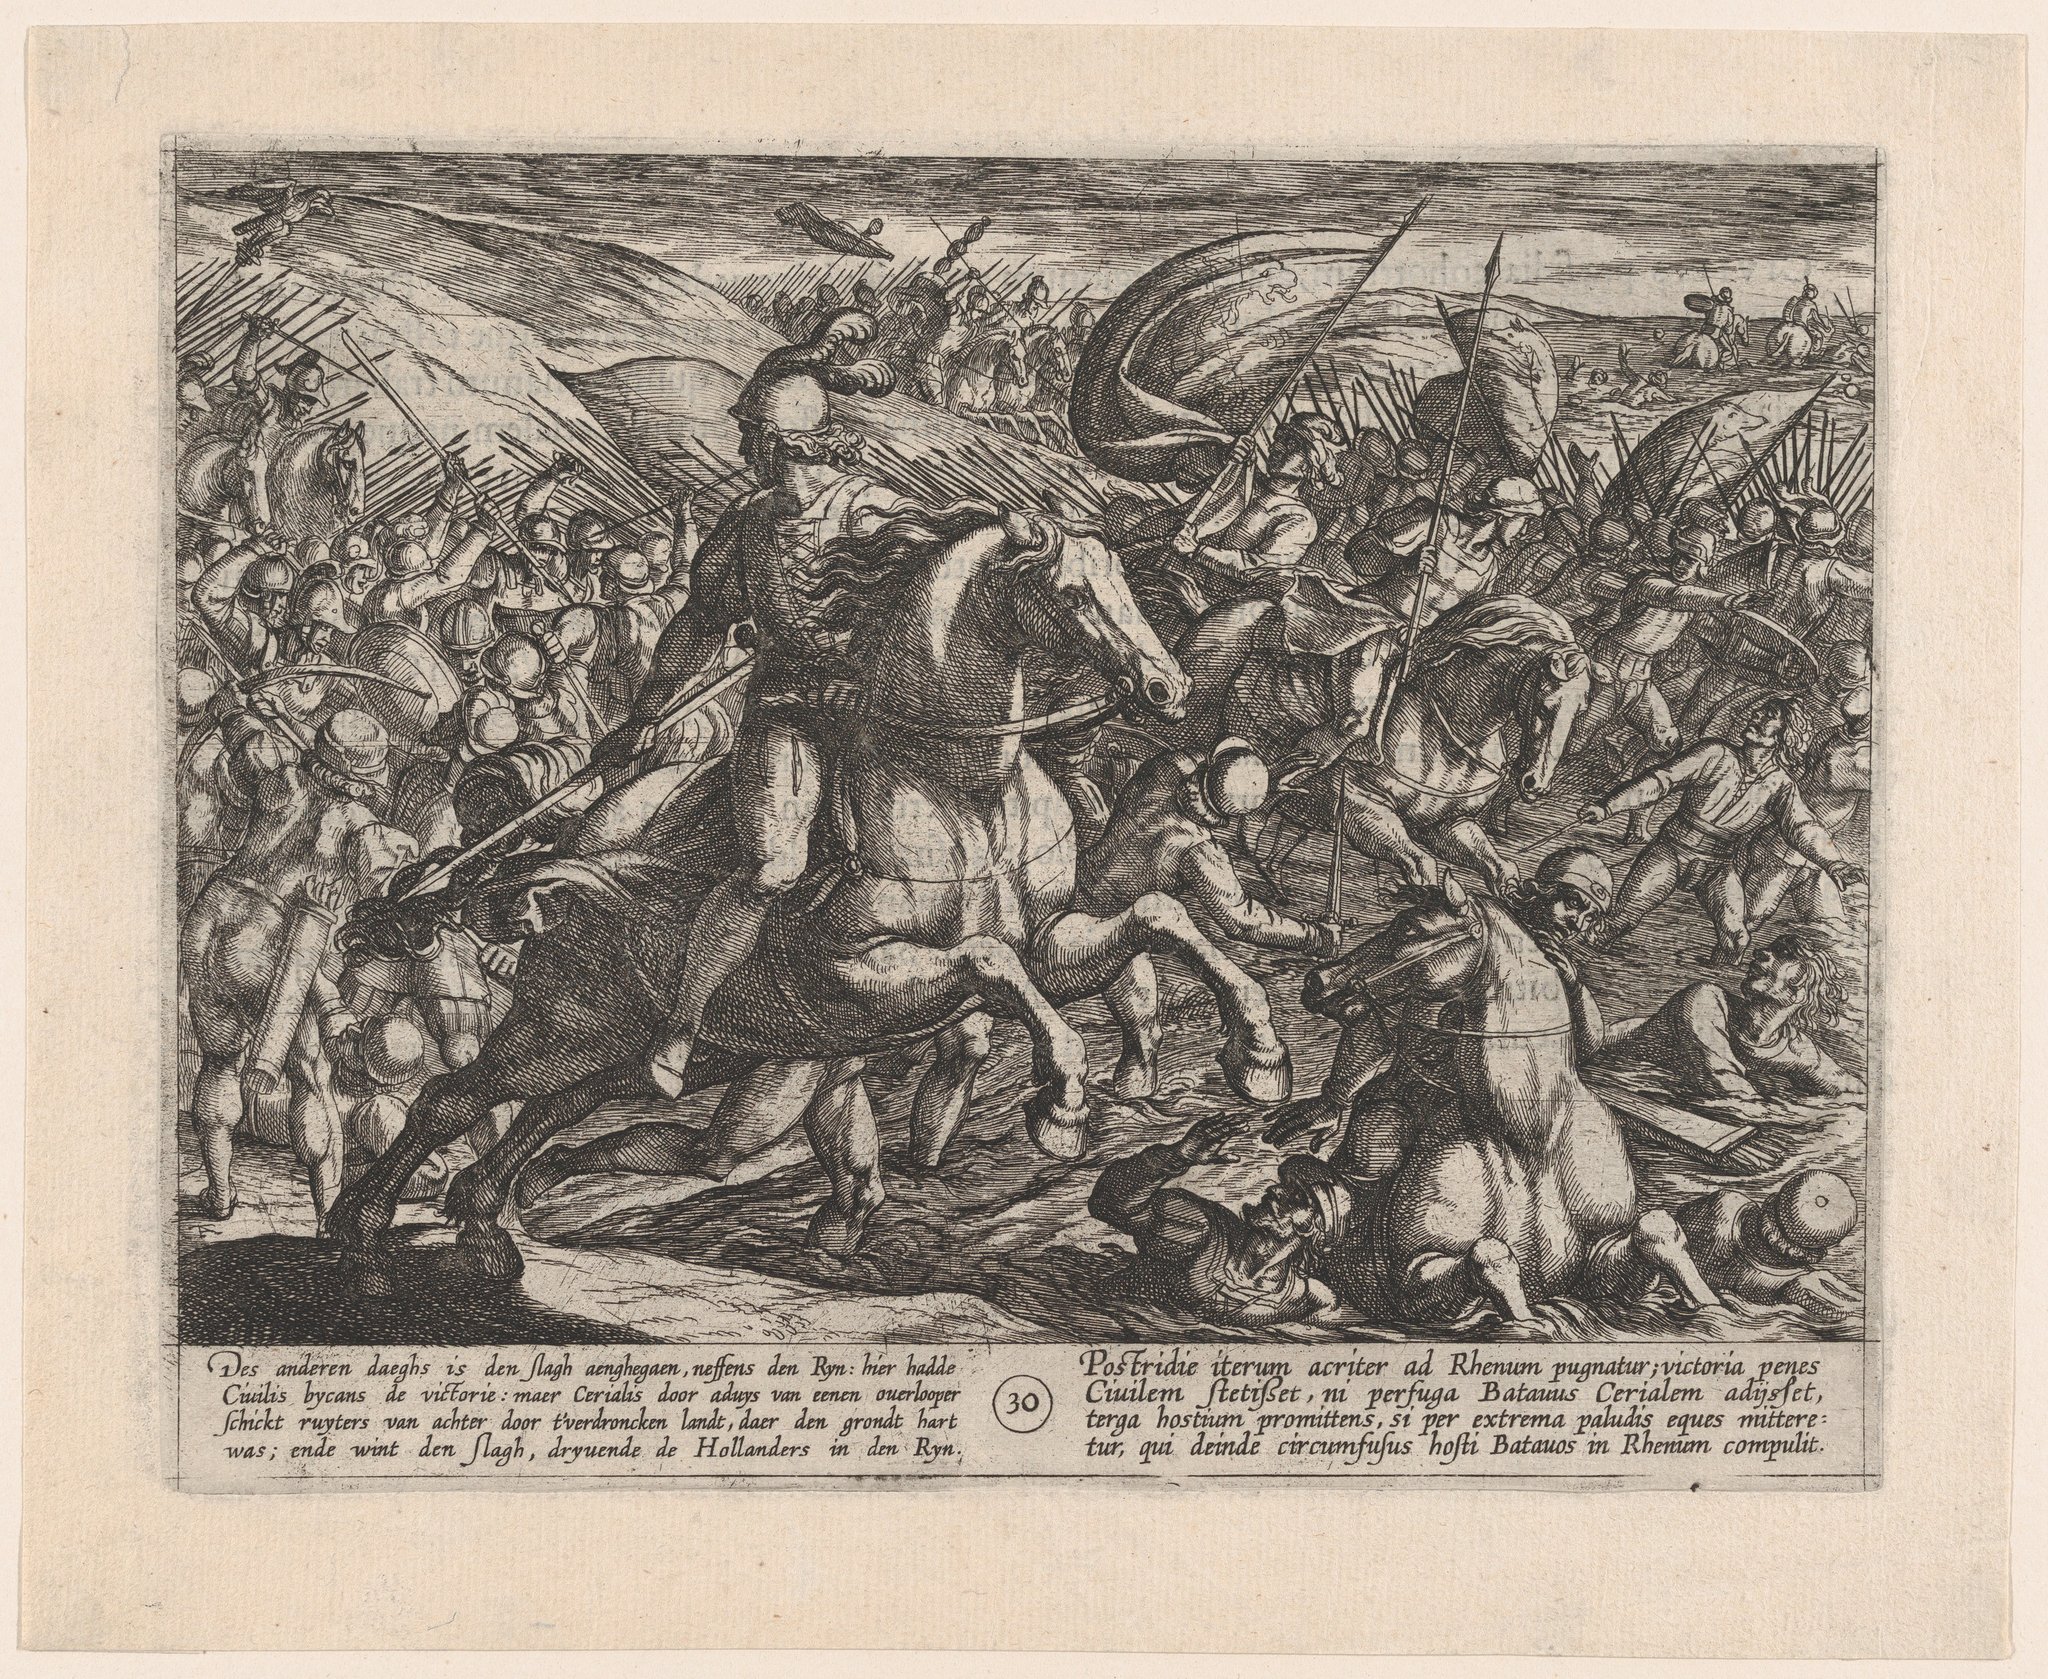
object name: print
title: Plate 30: Cerialis Driving the Dutch into the Rhine, from The War of the Romans Against the Batavians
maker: antonio tempesta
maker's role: artist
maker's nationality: italian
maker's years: 1555-1630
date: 1611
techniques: etching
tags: wars,soldiers,weapons,horses